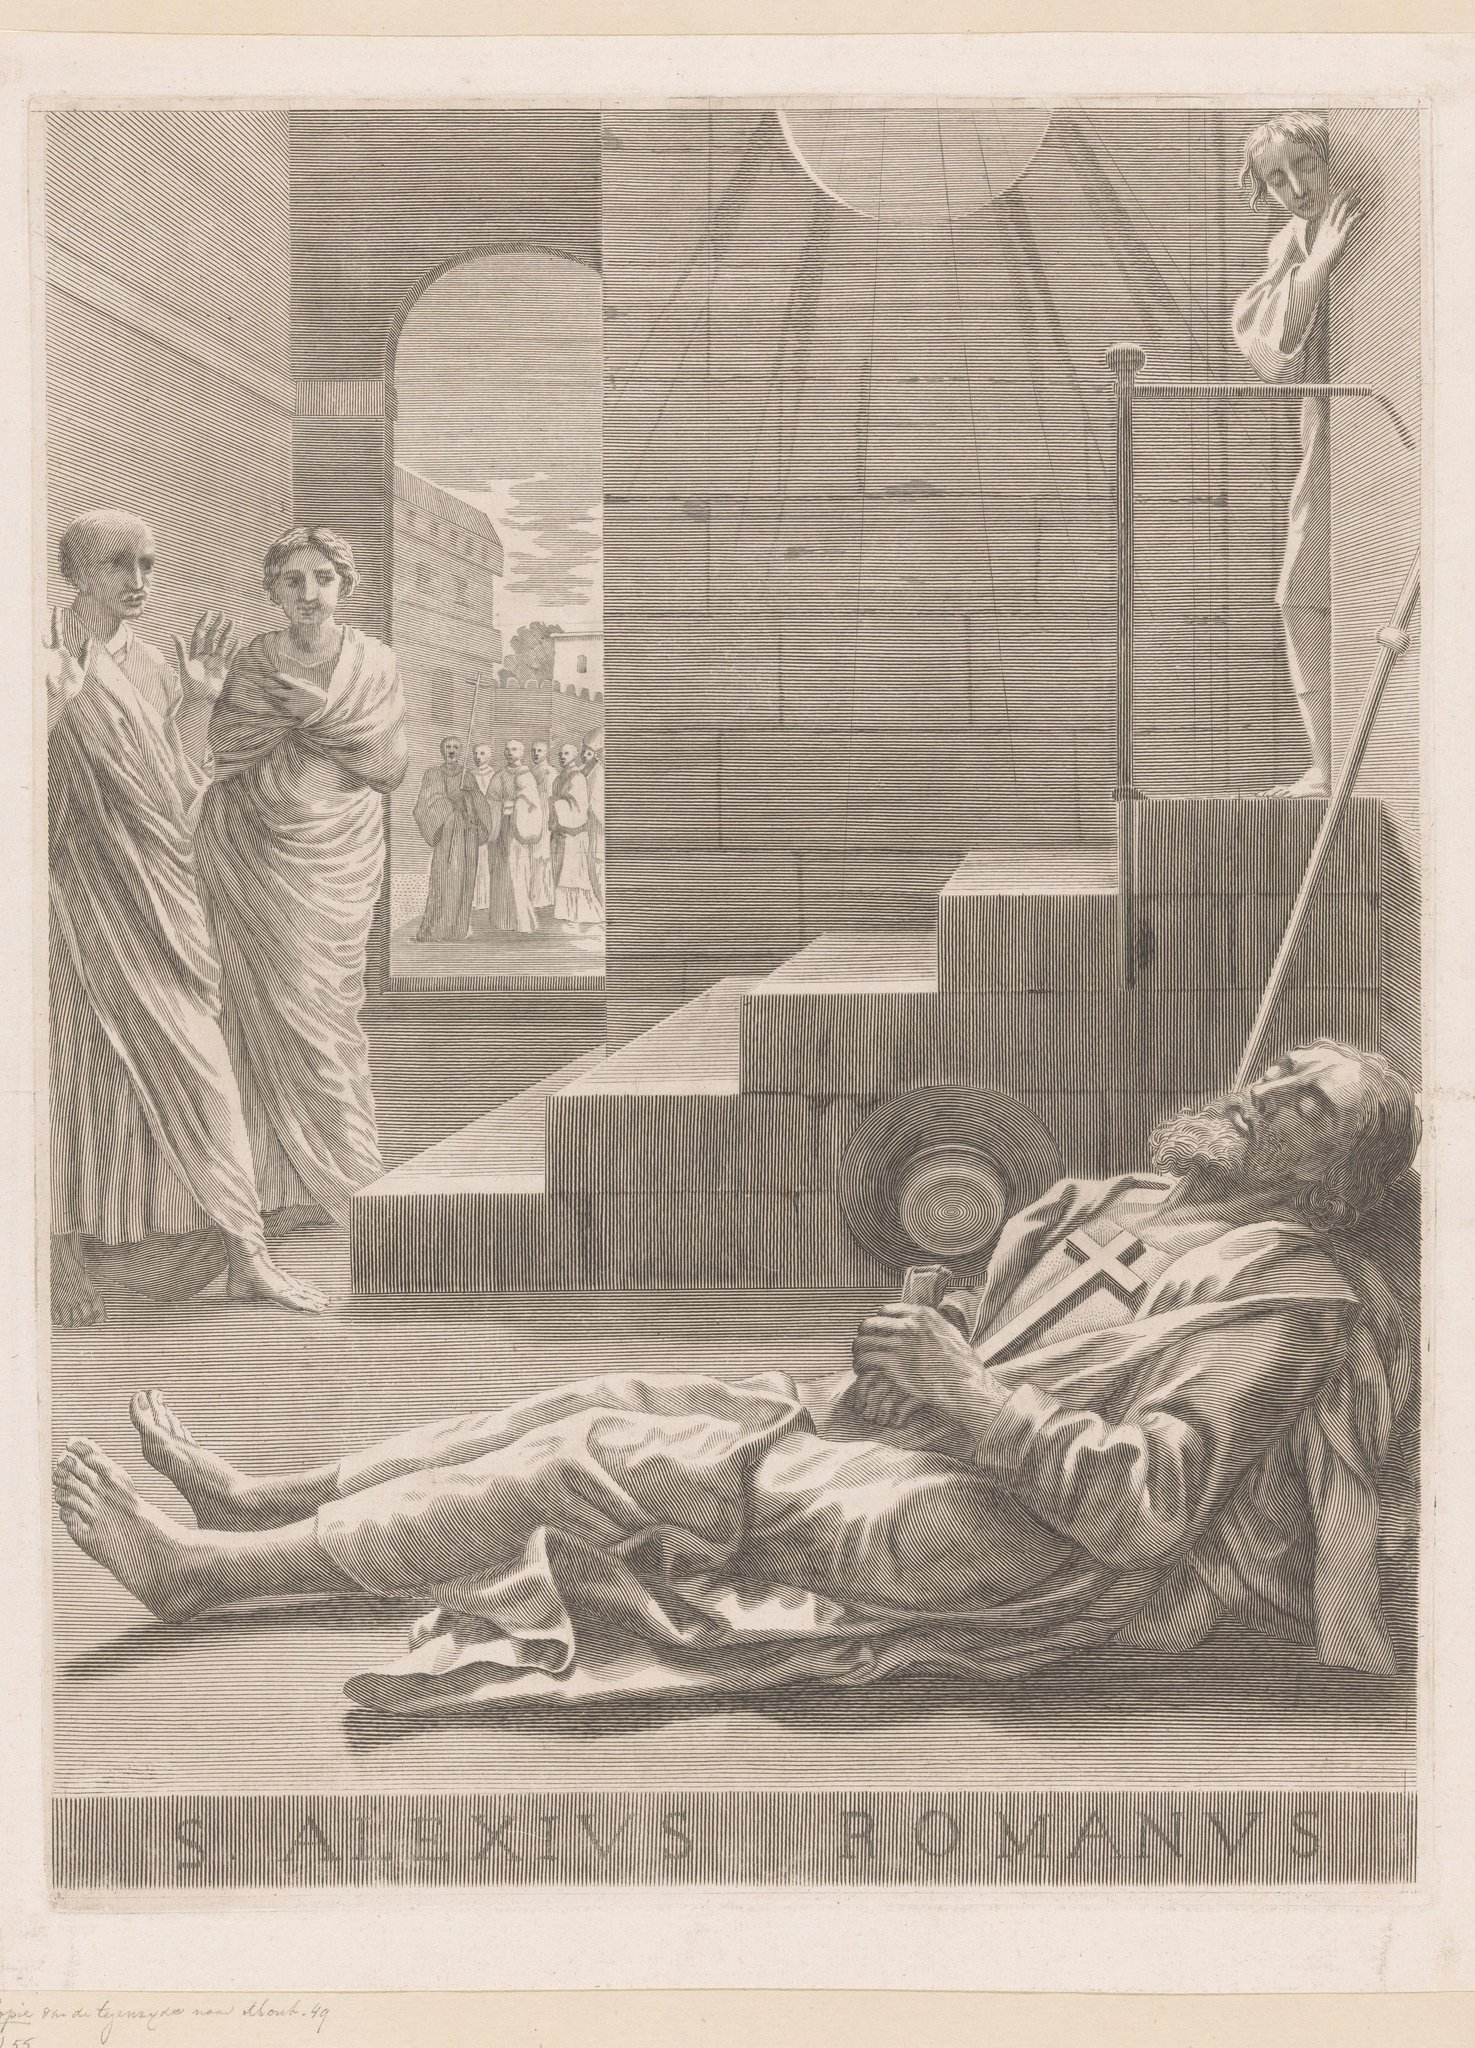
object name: print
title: Alexius van Edessa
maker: Anonymous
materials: paper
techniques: engraving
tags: the confessor alexi(u)s of rome (or edessa); possible attributes: staircase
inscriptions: collector's mark: Lugt 240